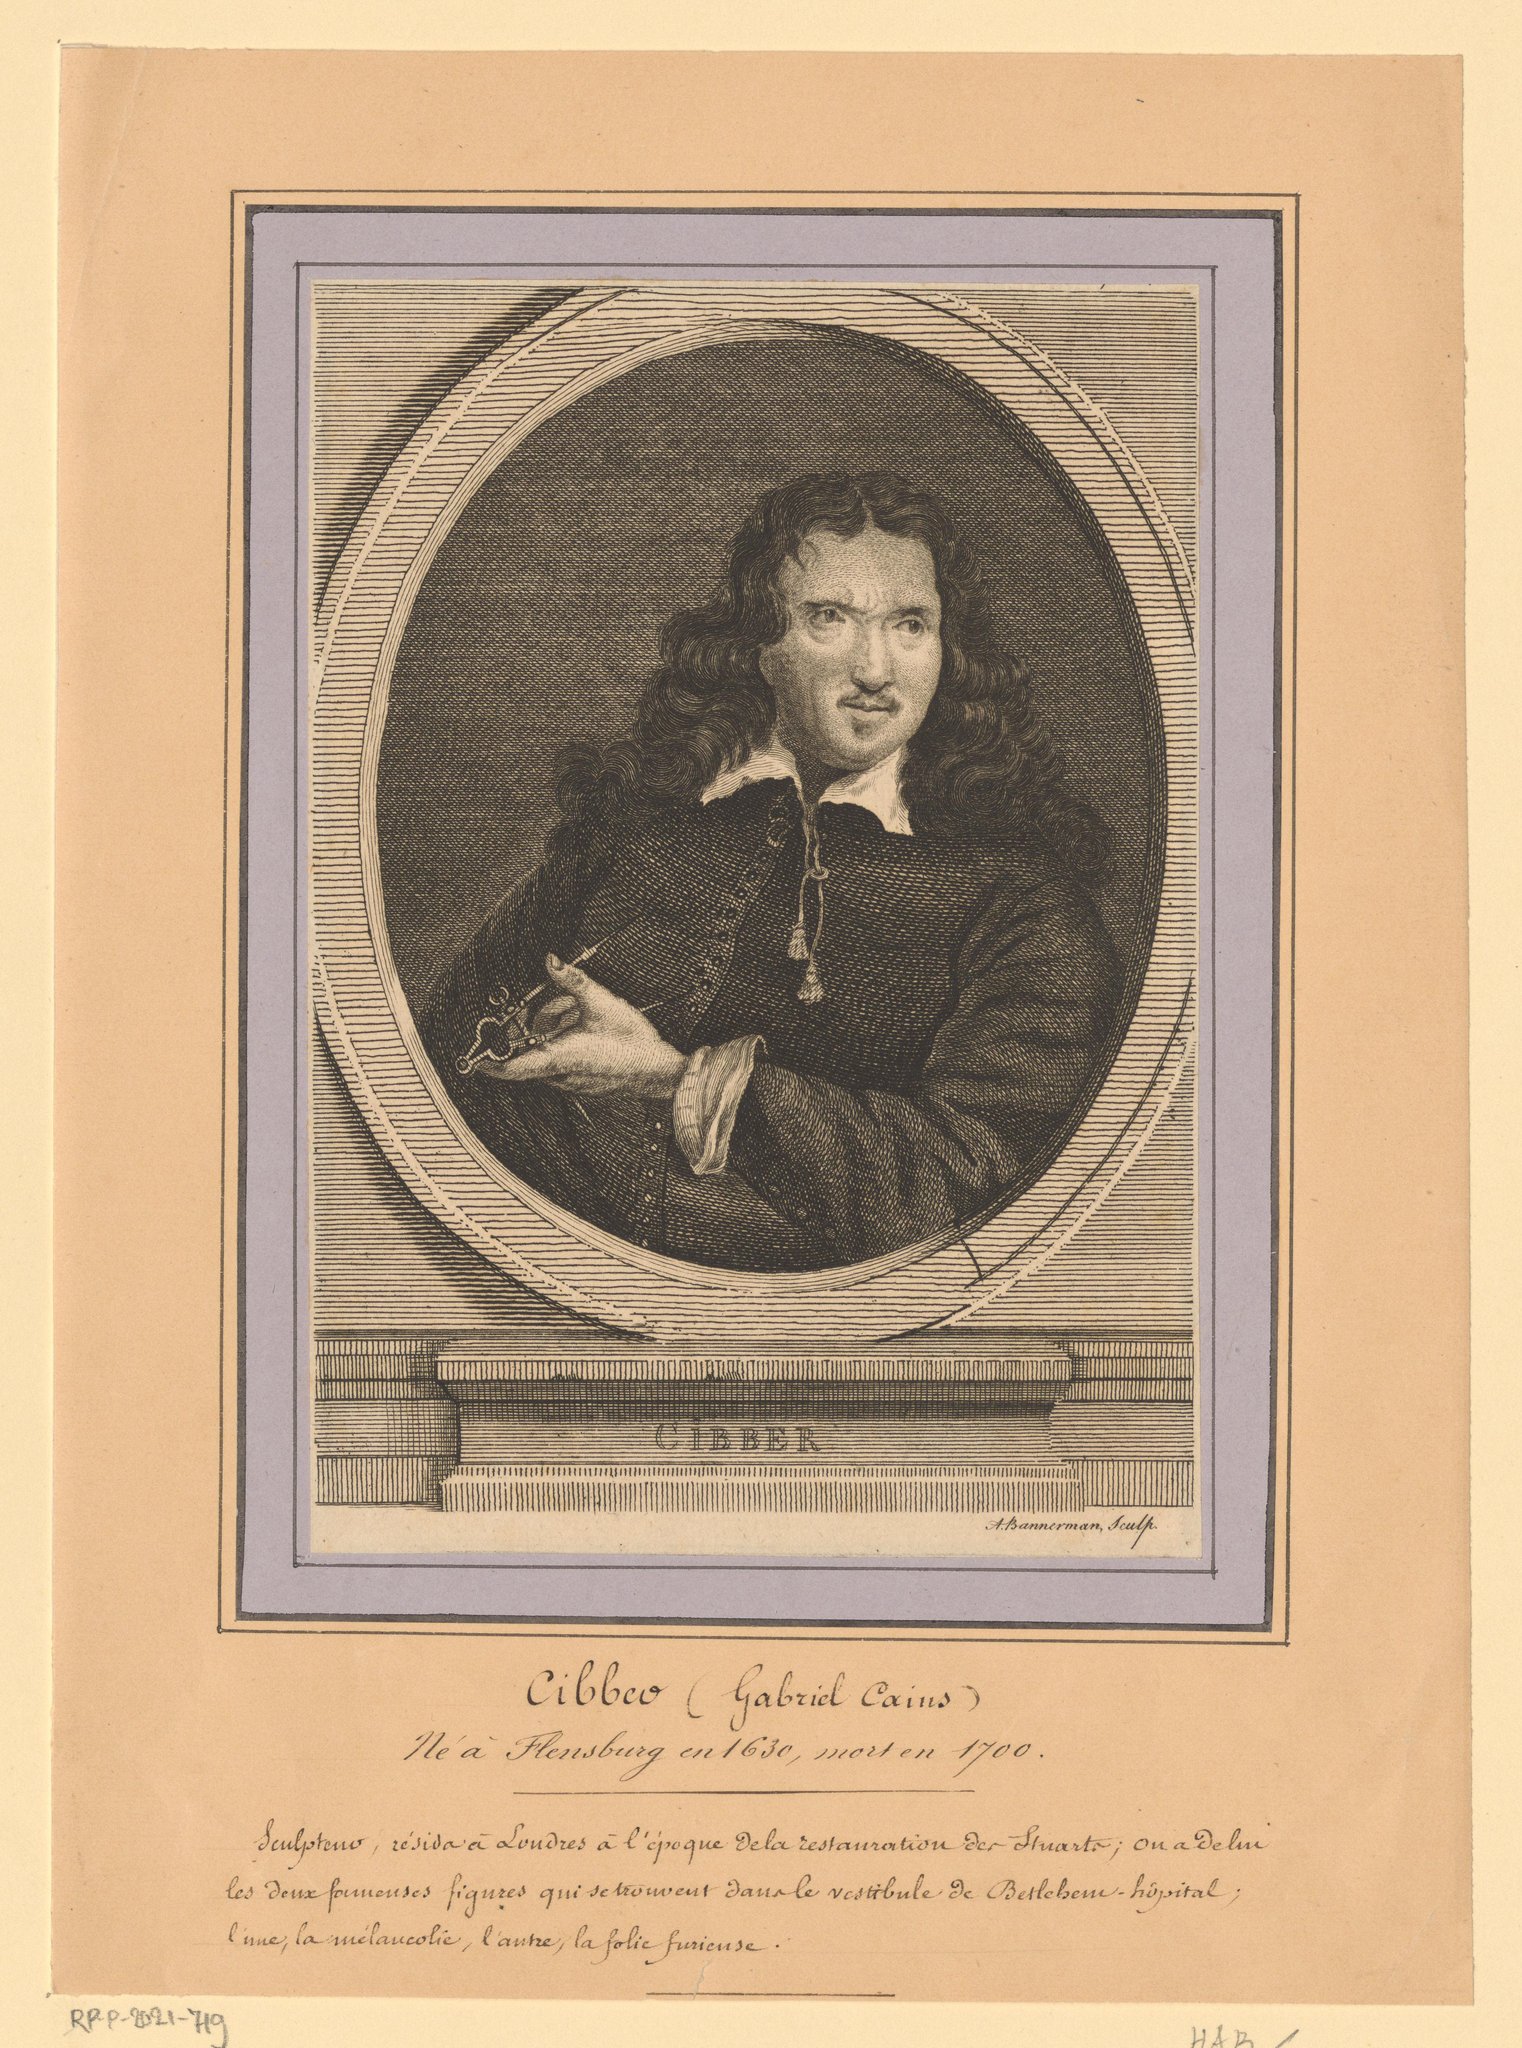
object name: print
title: Portret van Caius Gabriel Cibber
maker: alexander bannerman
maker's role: print maker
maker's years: 1720-1799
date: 1730-1780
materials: paper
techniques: engraving, etching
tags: sculptor, caius gabriel cibber, historical persons, portrait, self-portrait of architect